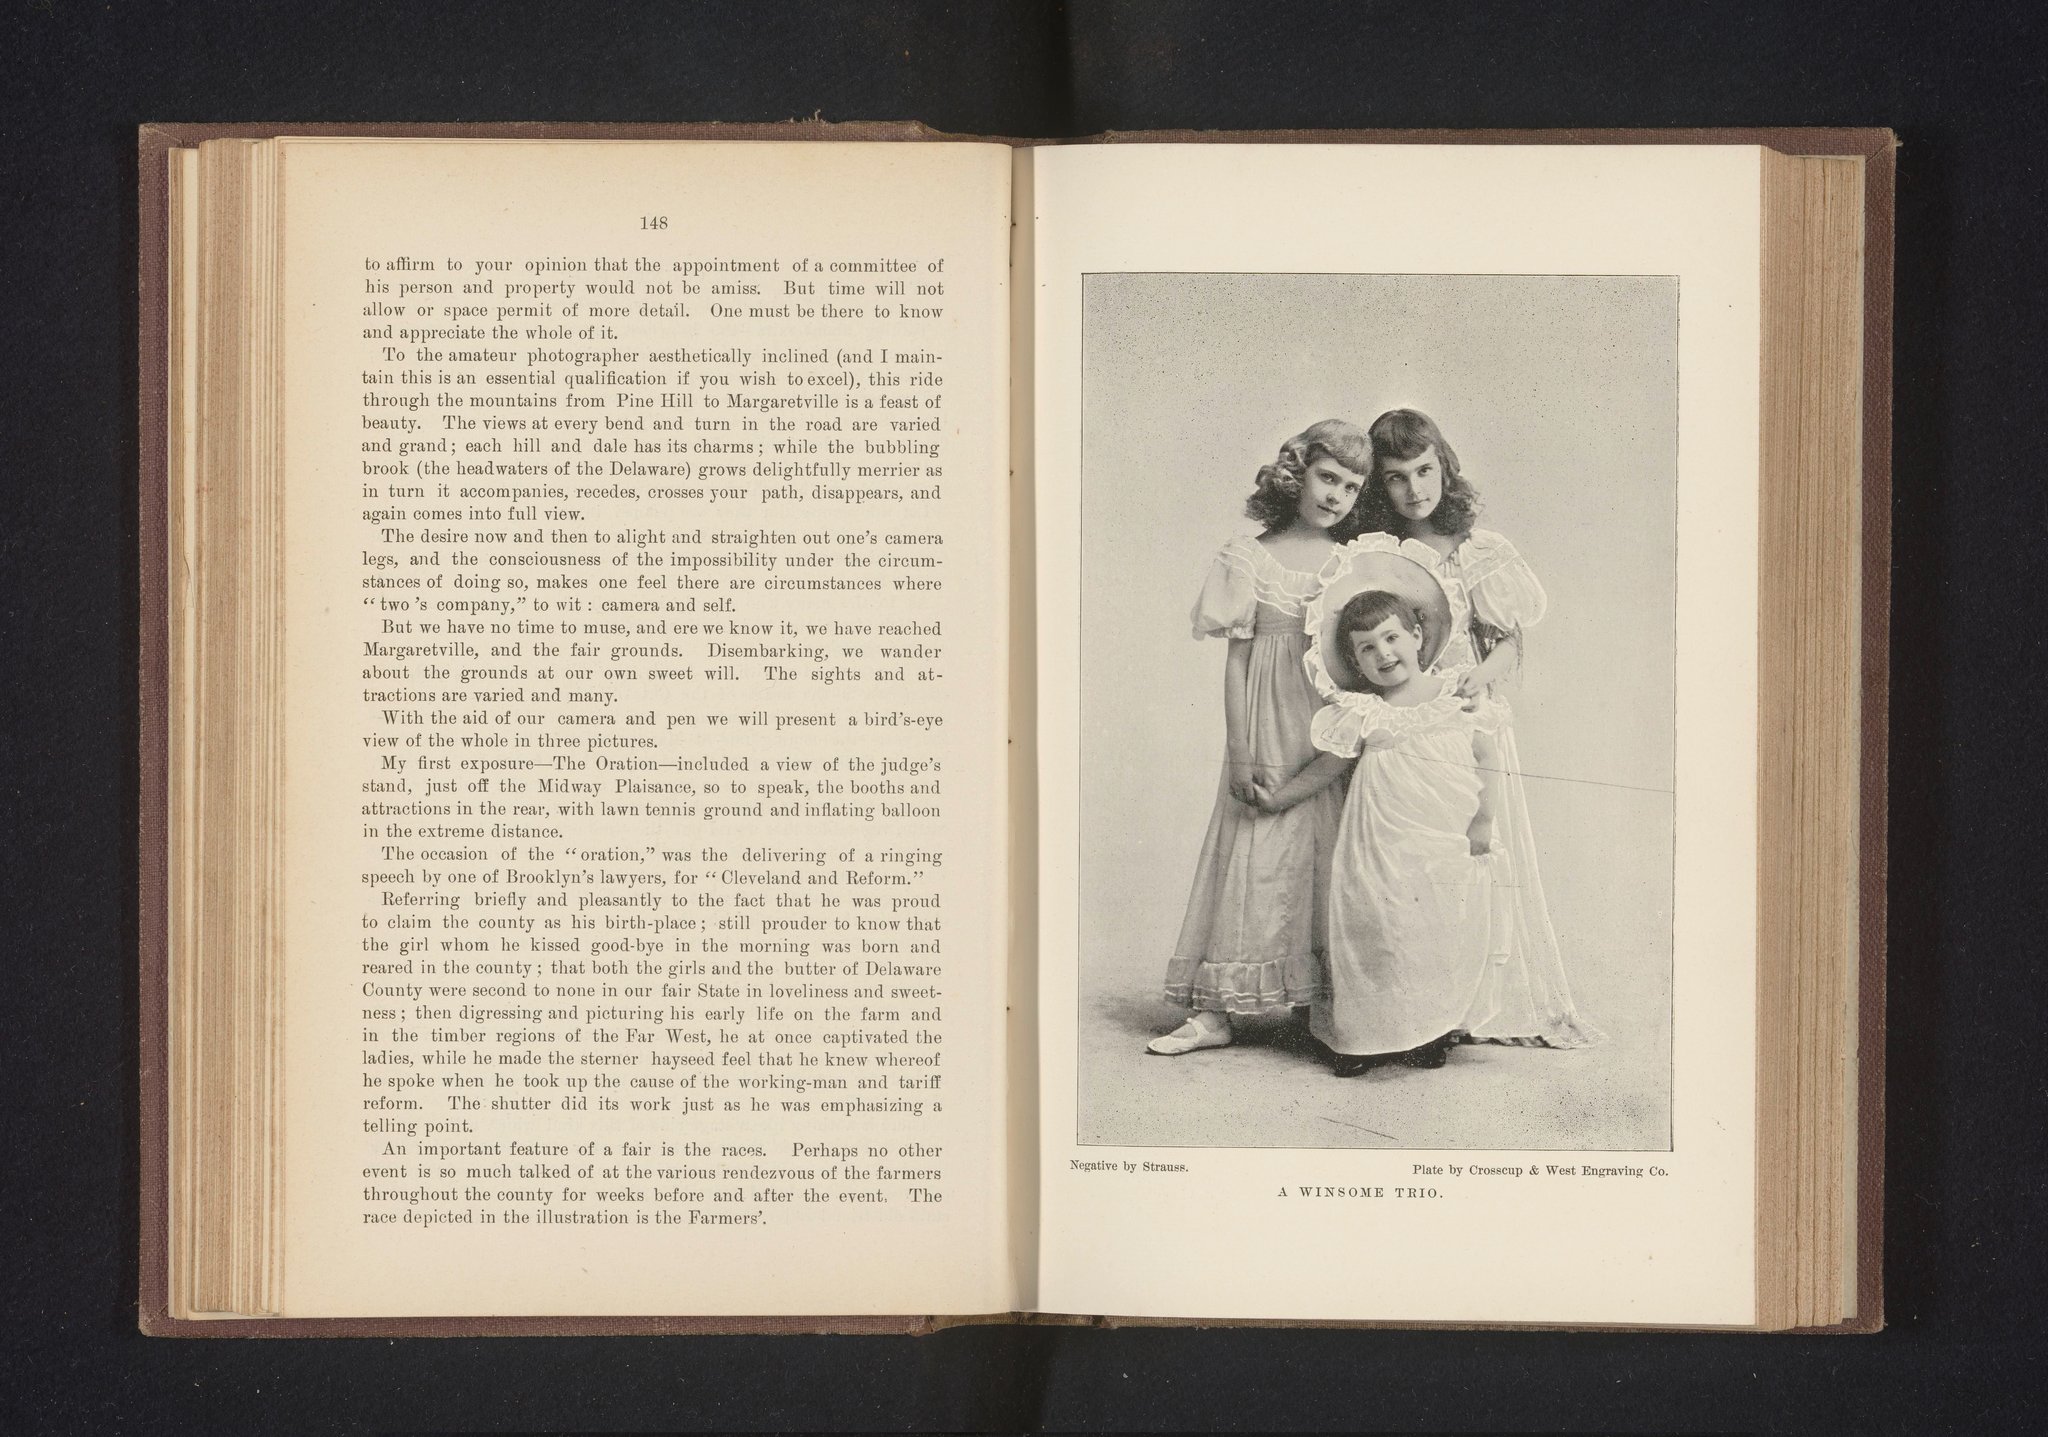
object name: page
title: A winsome trio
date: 1888-1893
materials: paper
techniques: autotype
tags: girl (child between toddler and youth)